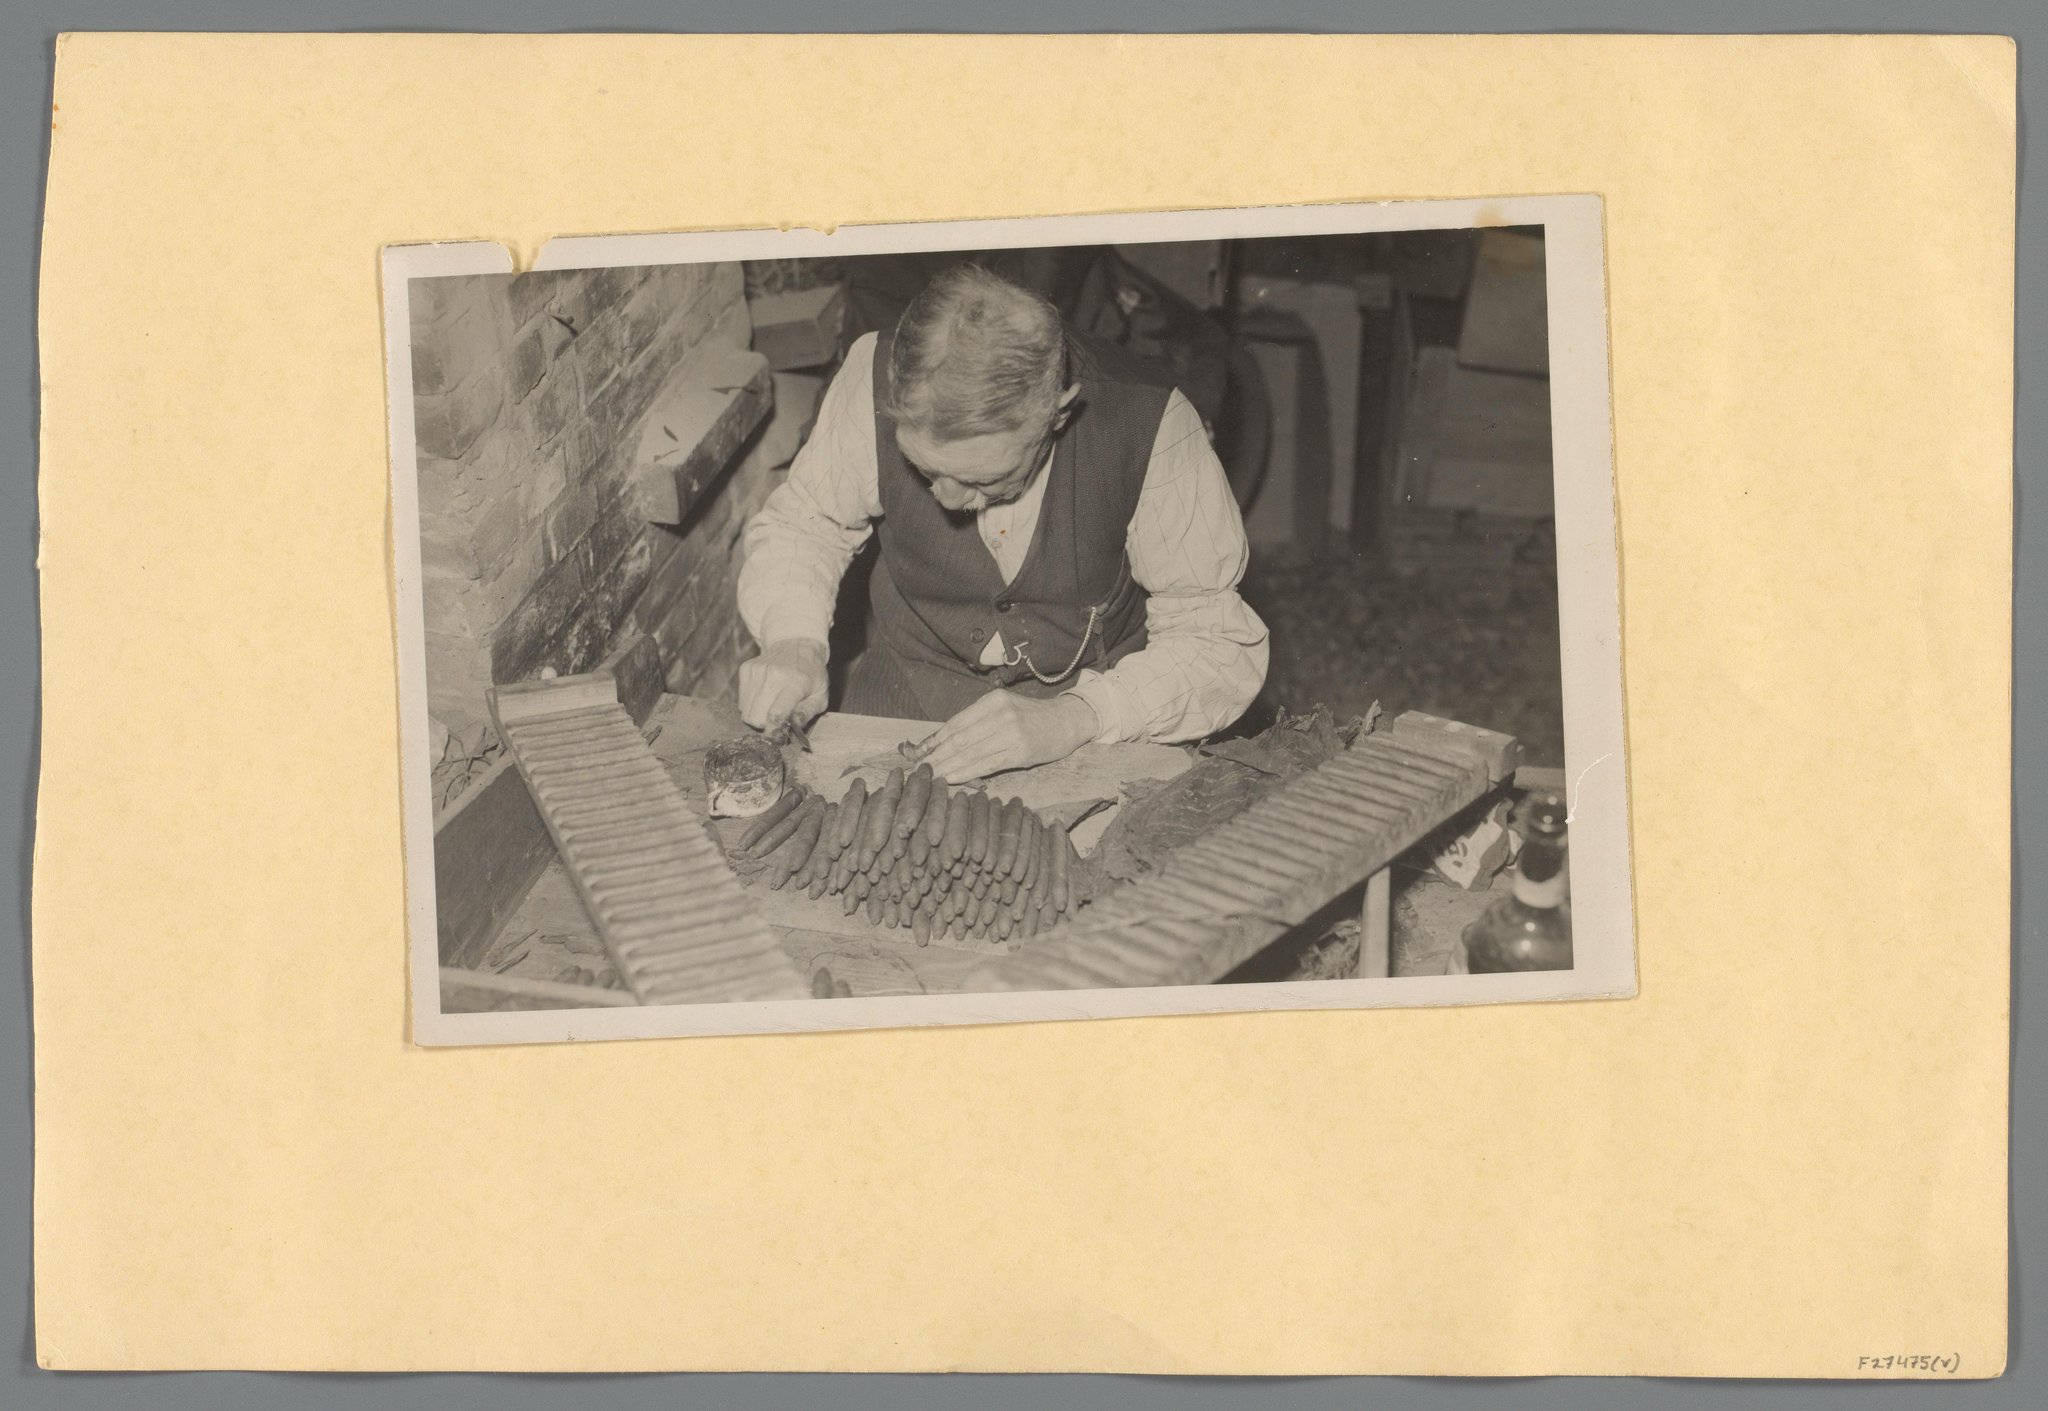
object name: photograph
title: Albumblad met een foto van een sigarenmaker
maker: Anonymous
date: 1930-1940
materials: paper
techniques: gelatin silver print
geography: netherlands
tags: cigar, netherlands